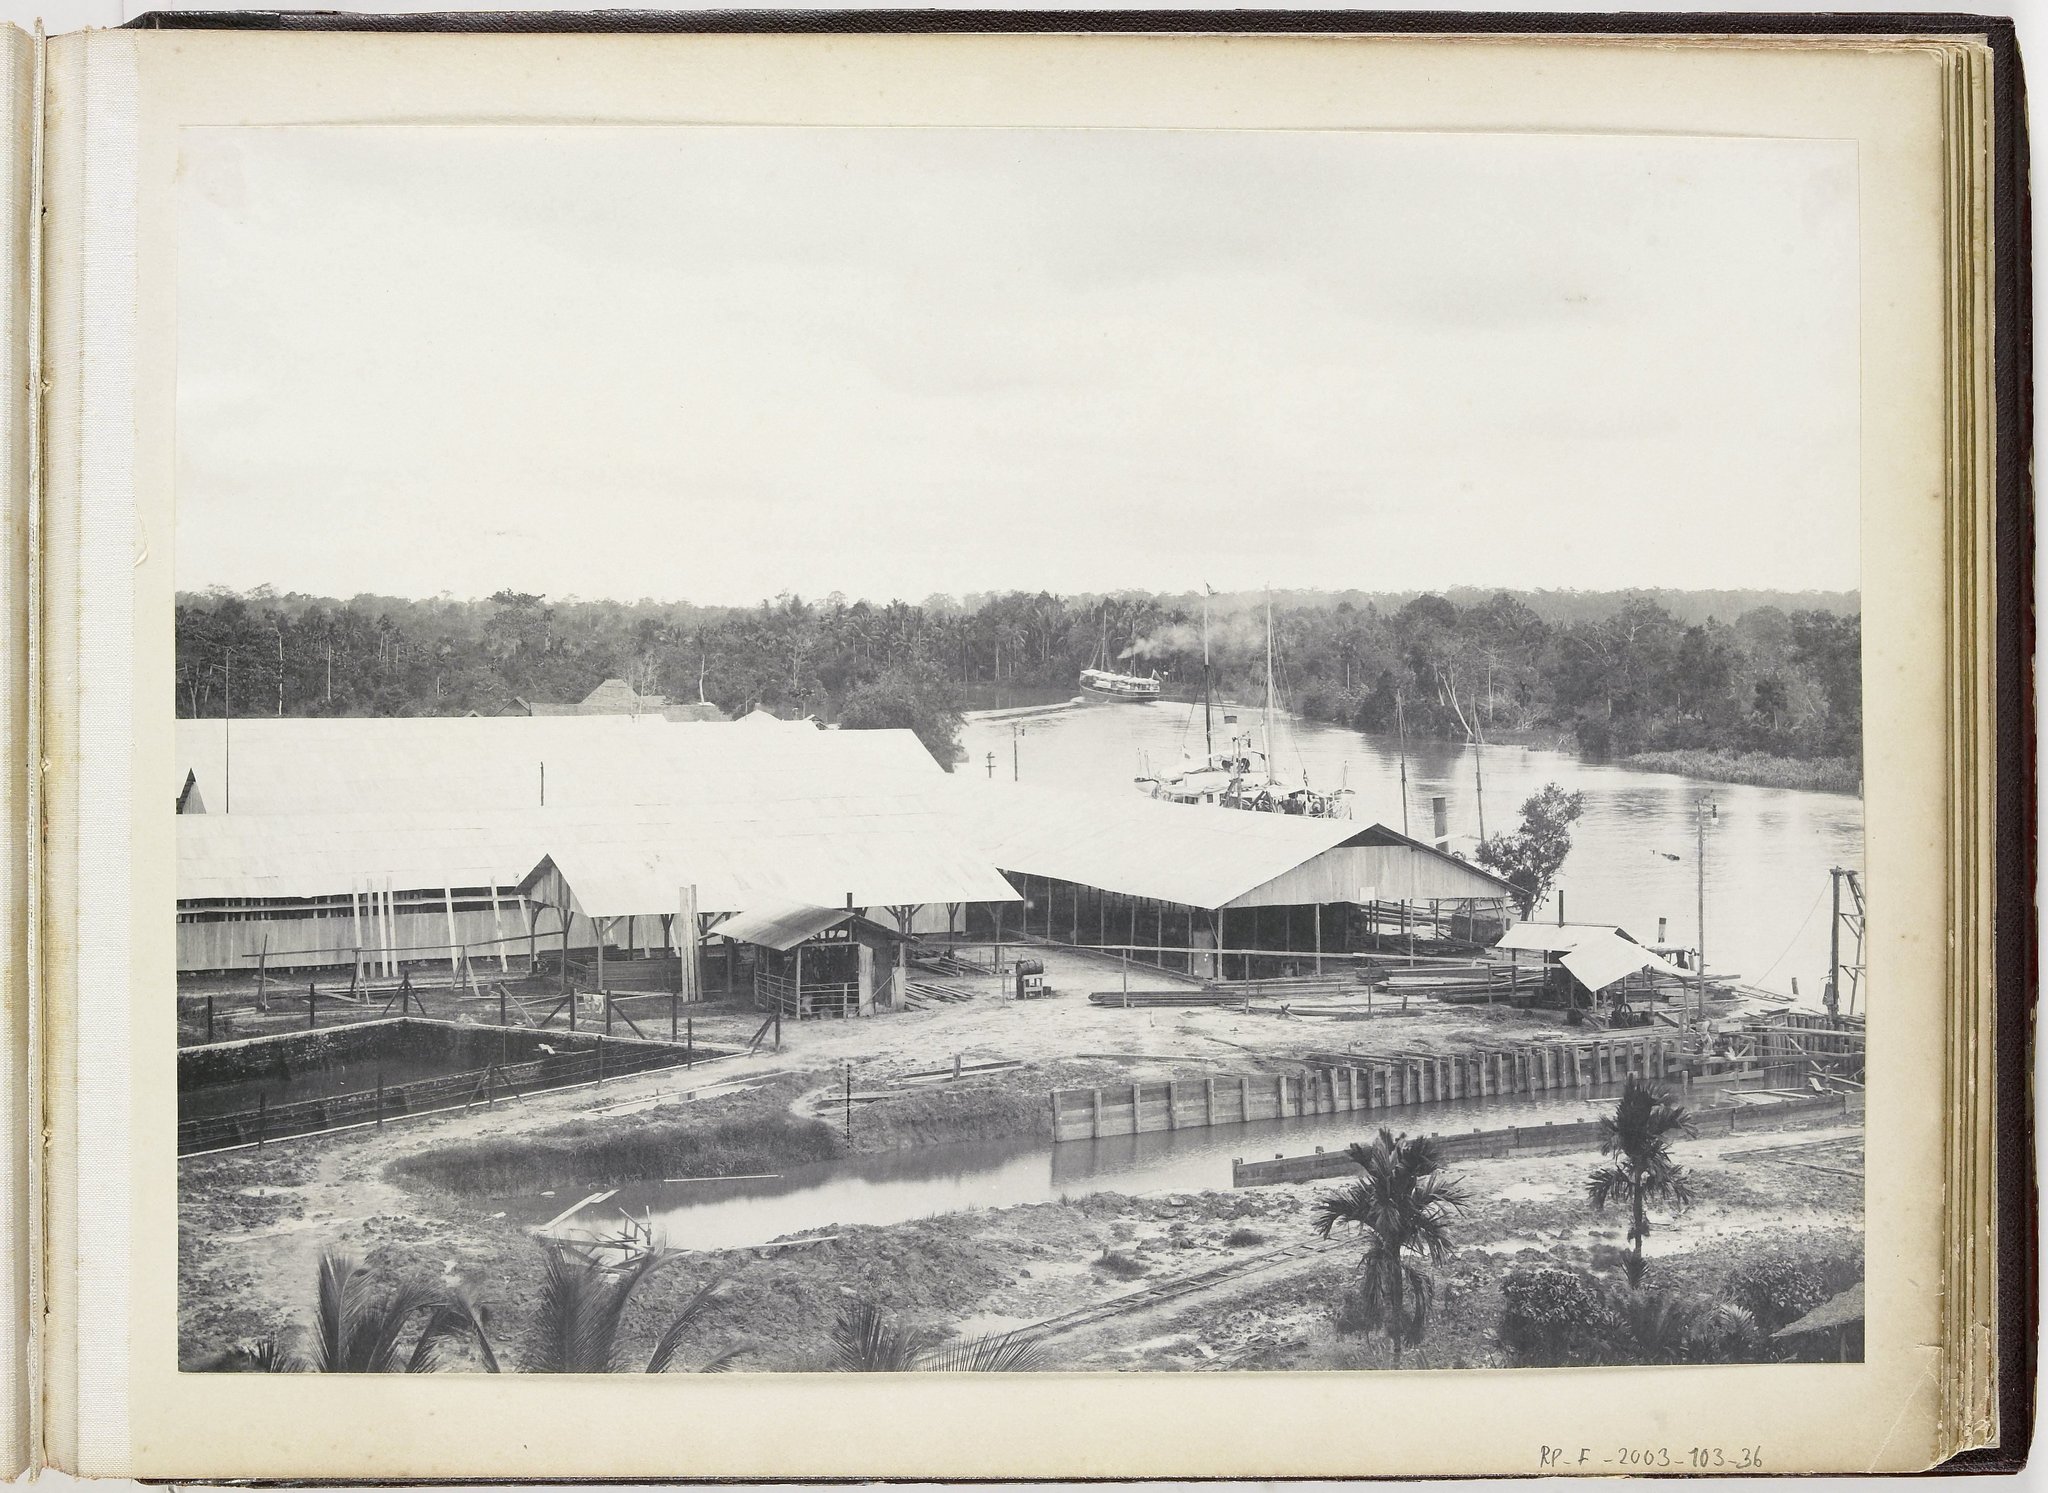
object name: photograph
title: Gezicht op Sandelwerf (?), Tandjong Poera, Langkat Sumatra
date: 1900-1905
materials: cardboard, paper, photographic support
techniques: platinum process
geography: bindjai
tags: sumatra